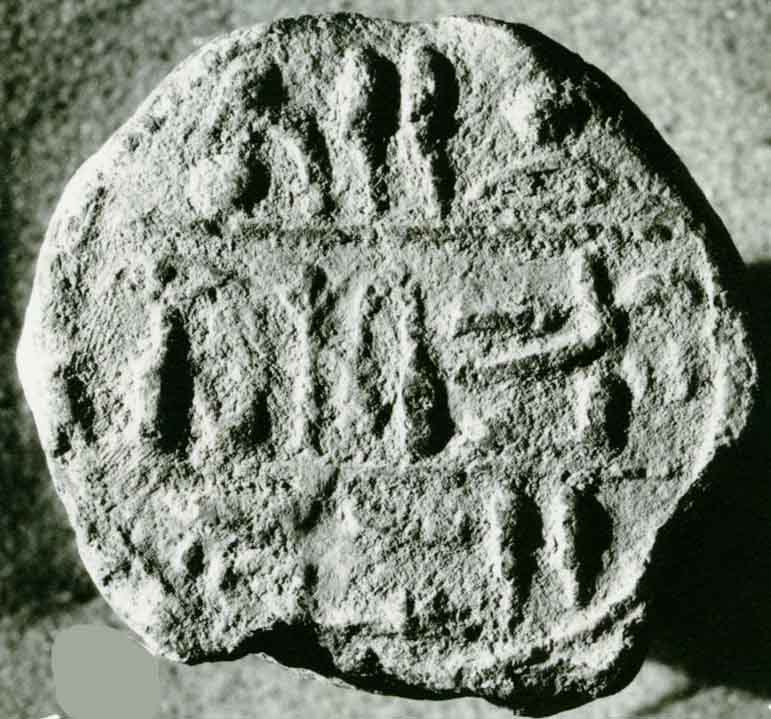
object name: cone, circular impression, maaty, scribe, huy, house mistress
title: Funerary Cone of the Scribe Maaty and His Wife Huy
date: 1550-1295 BCE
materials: pottery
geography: egypt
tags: hieroglyphs